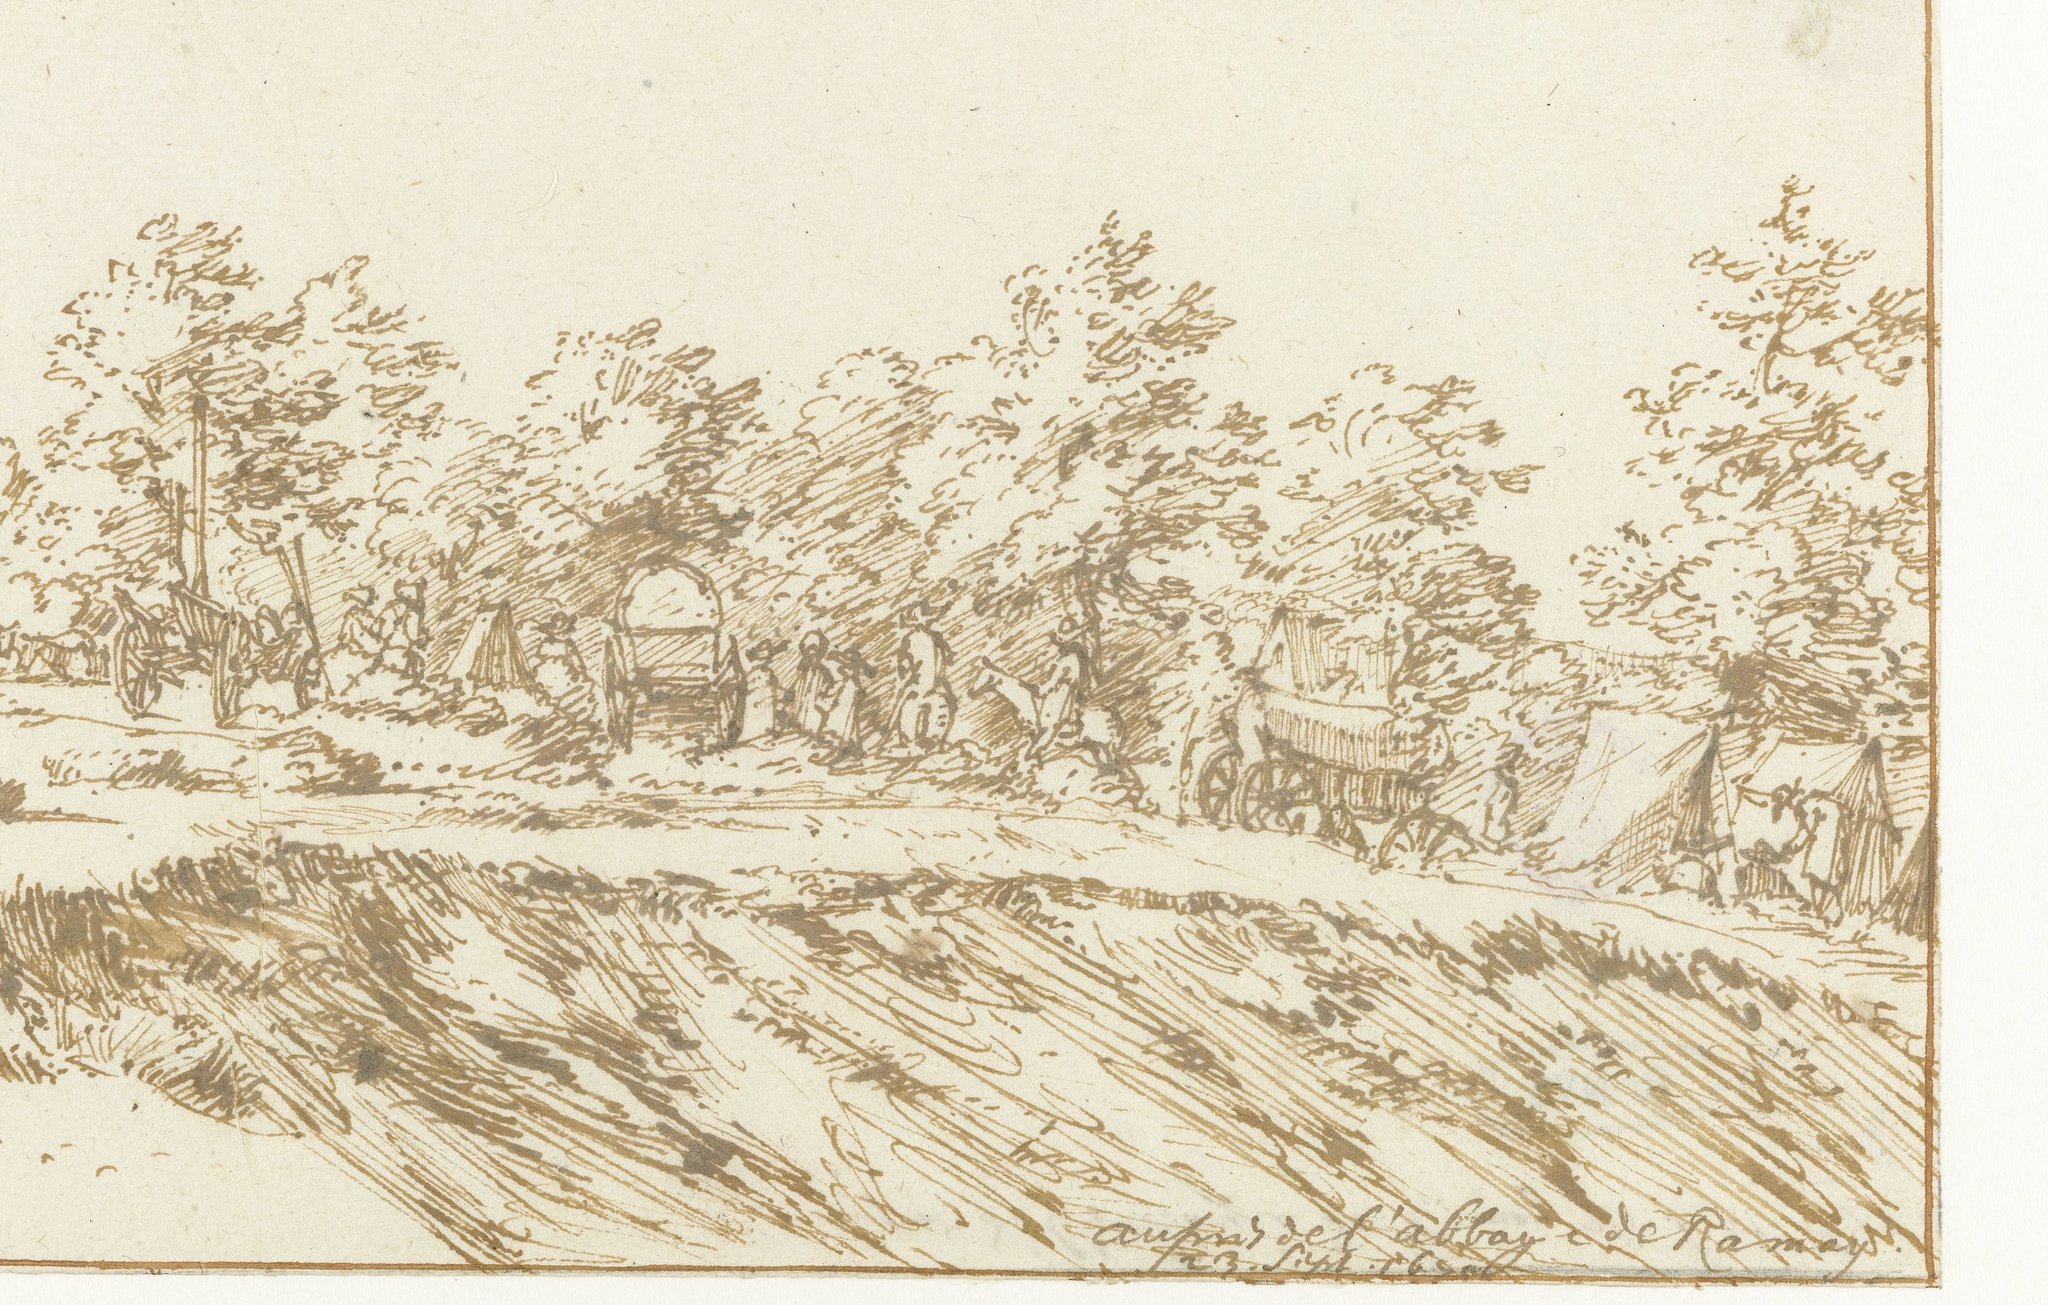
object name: drawing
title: Aupres de l'abbaye de Ramay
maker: constantijn huygens (ii)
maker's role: draughtsman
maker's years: 1628-1697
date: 1675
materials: ink, paper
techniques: pen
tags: (military) camp with tents